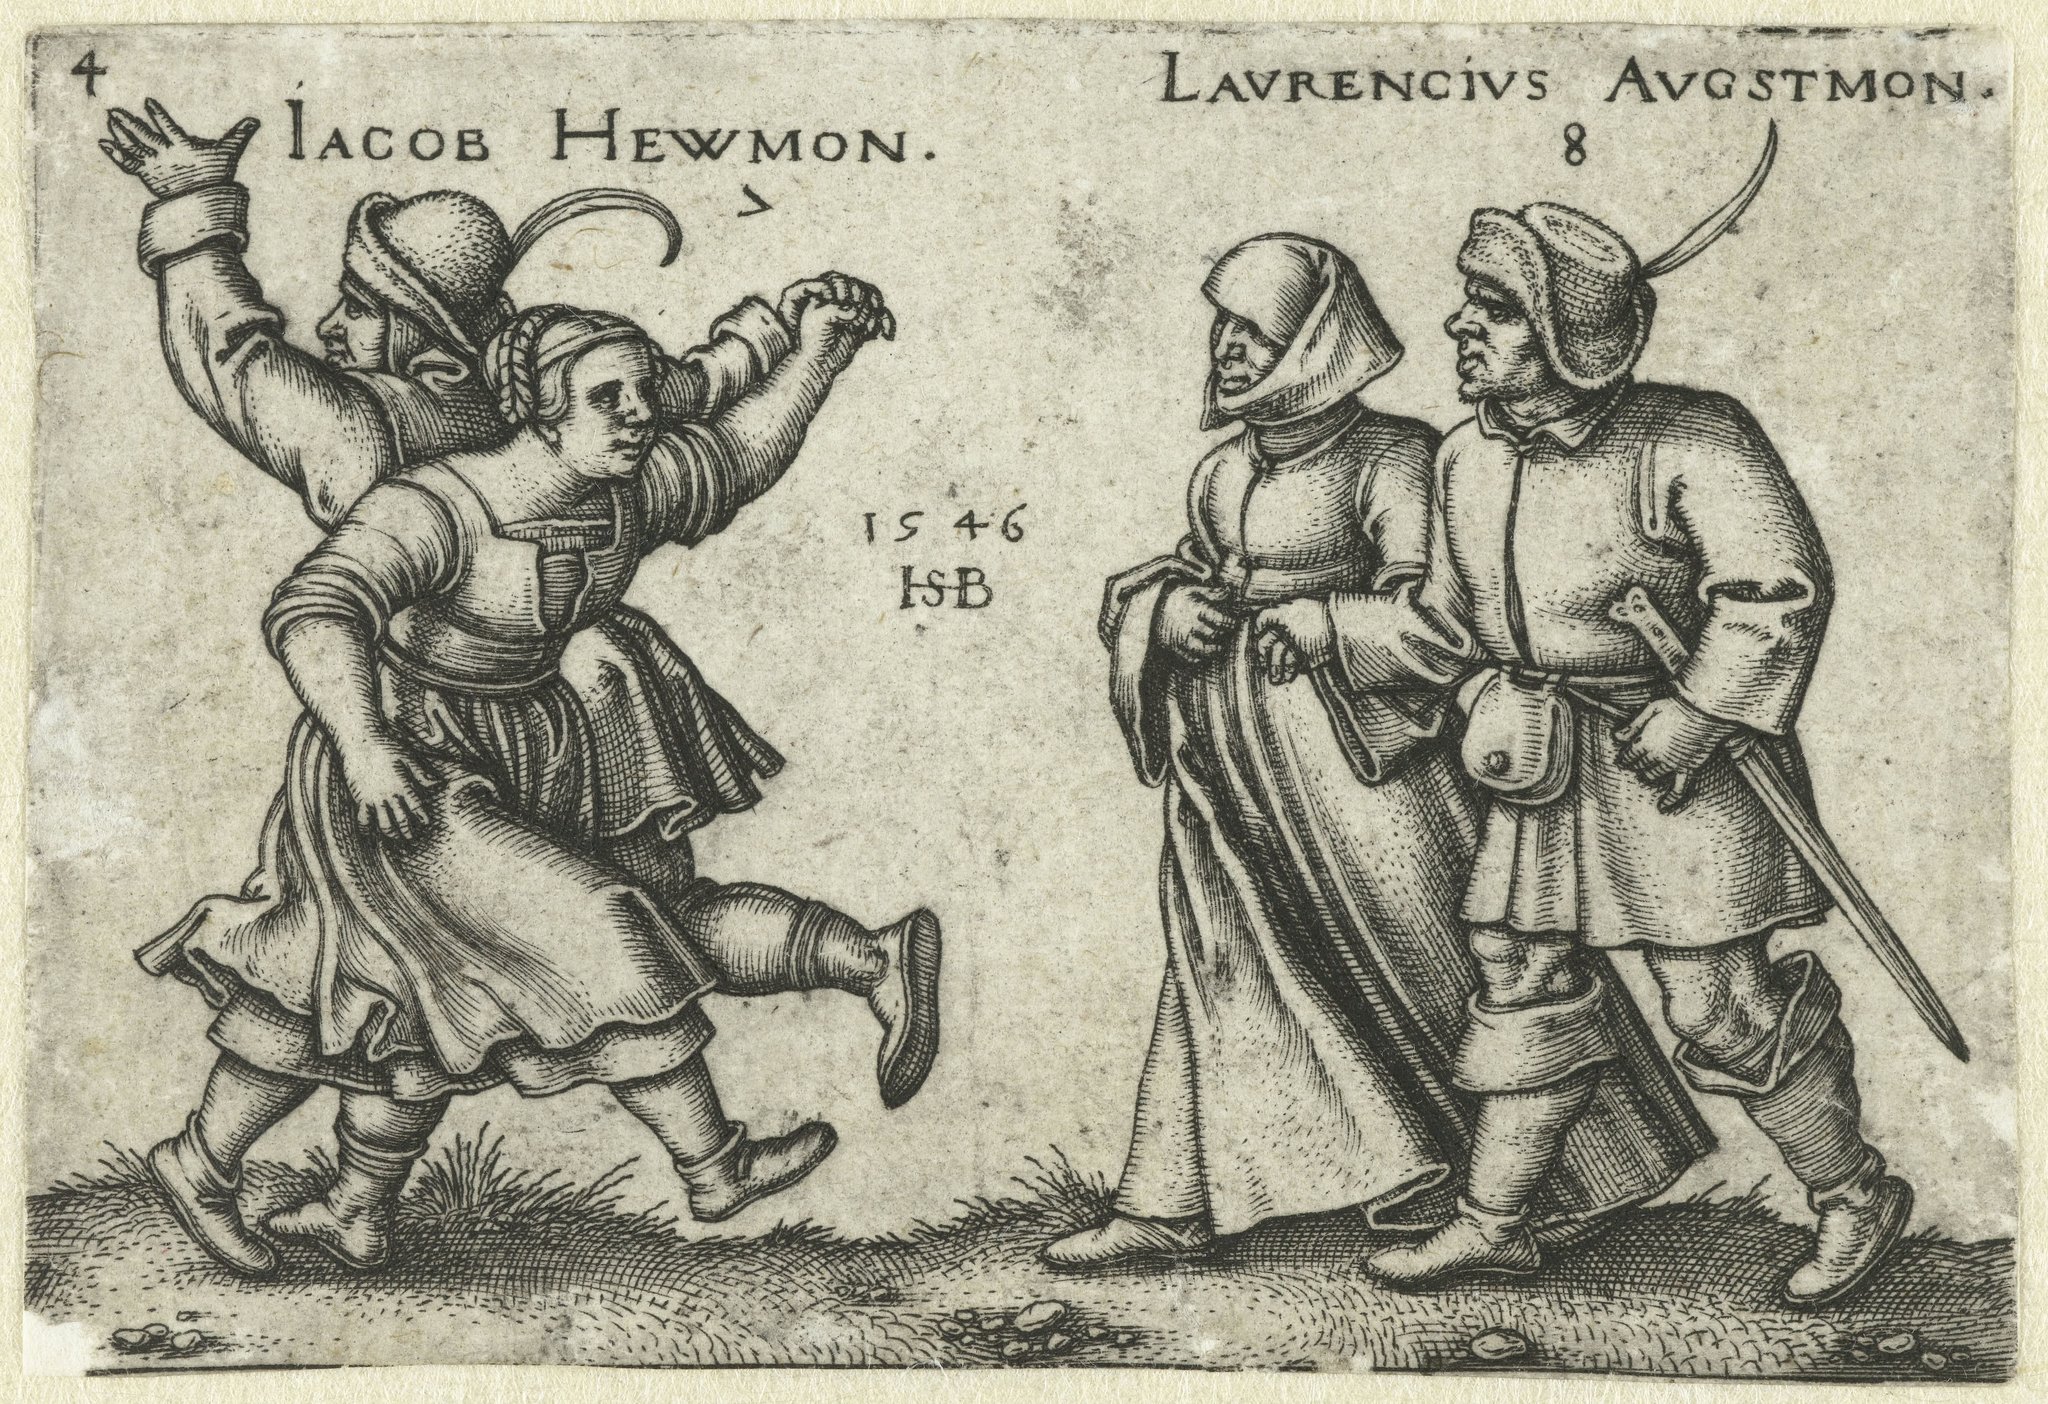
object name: print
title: Juli en Augustus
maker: hans sebald beham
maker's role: designer, draughtsman, print maker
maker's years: 1500-1550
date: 1546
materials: paper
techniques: engraving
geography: frankfurt am main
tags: one pair dancing; man and woman dancing as a couple, farmers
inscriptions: collector's mark: ‘Hinloopen’ Lugt 11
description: De twaalf dansende boerenparen van deze serie prenten vertegenwoordigen de twaalf maanden. Volgens de opschriften Iacob Hewmon[at] en Lavrencivs Avgstmon[at] gaat het hier om de maanden Juli en Augustus